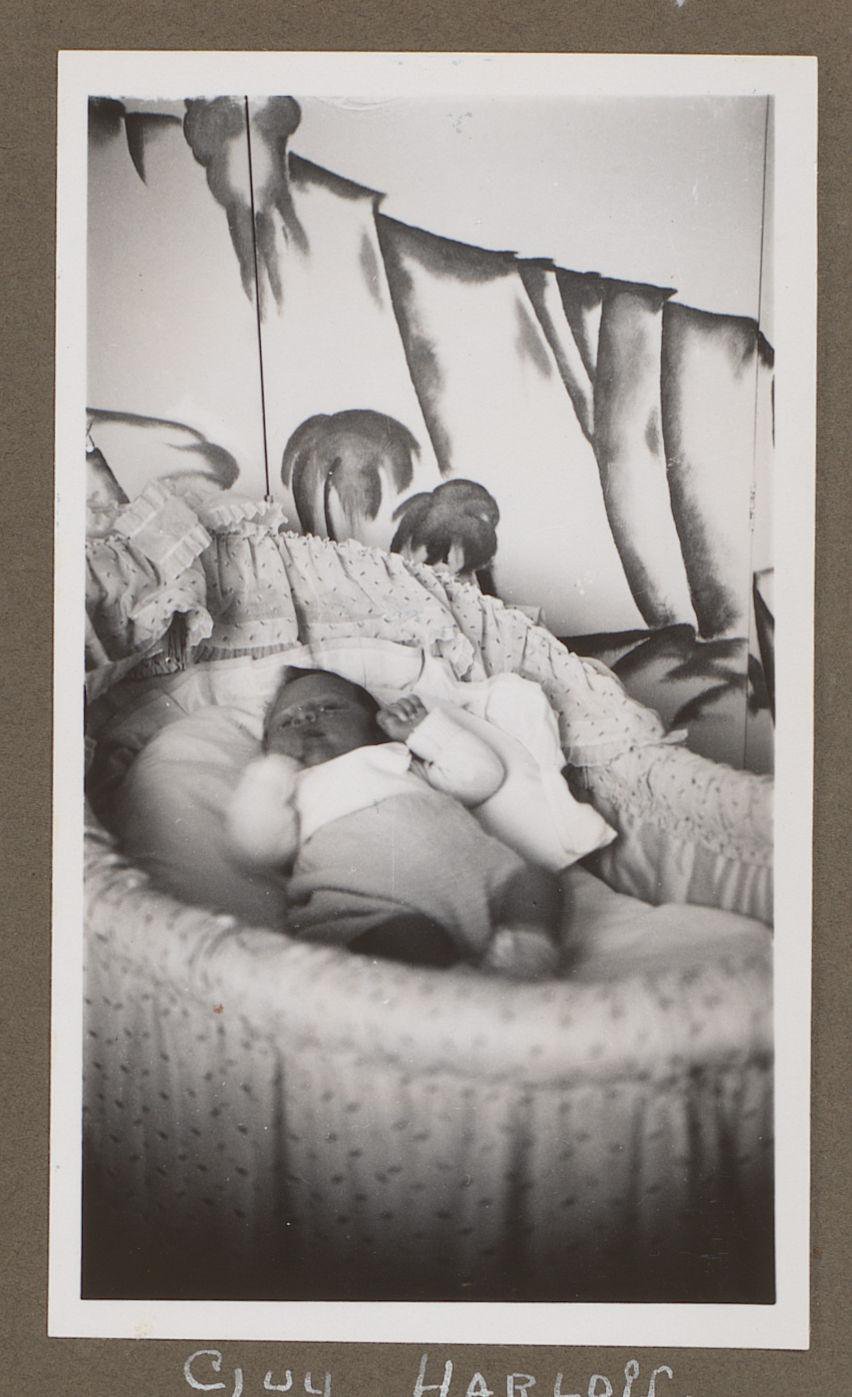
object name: photograph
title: Guy Harloff in een ledikant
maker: Anonymous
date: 1934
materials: paper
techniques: gelatin silver print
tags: paris, painter, draughtsman, male infant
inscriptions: inscription: ‘Guy Harloff.’